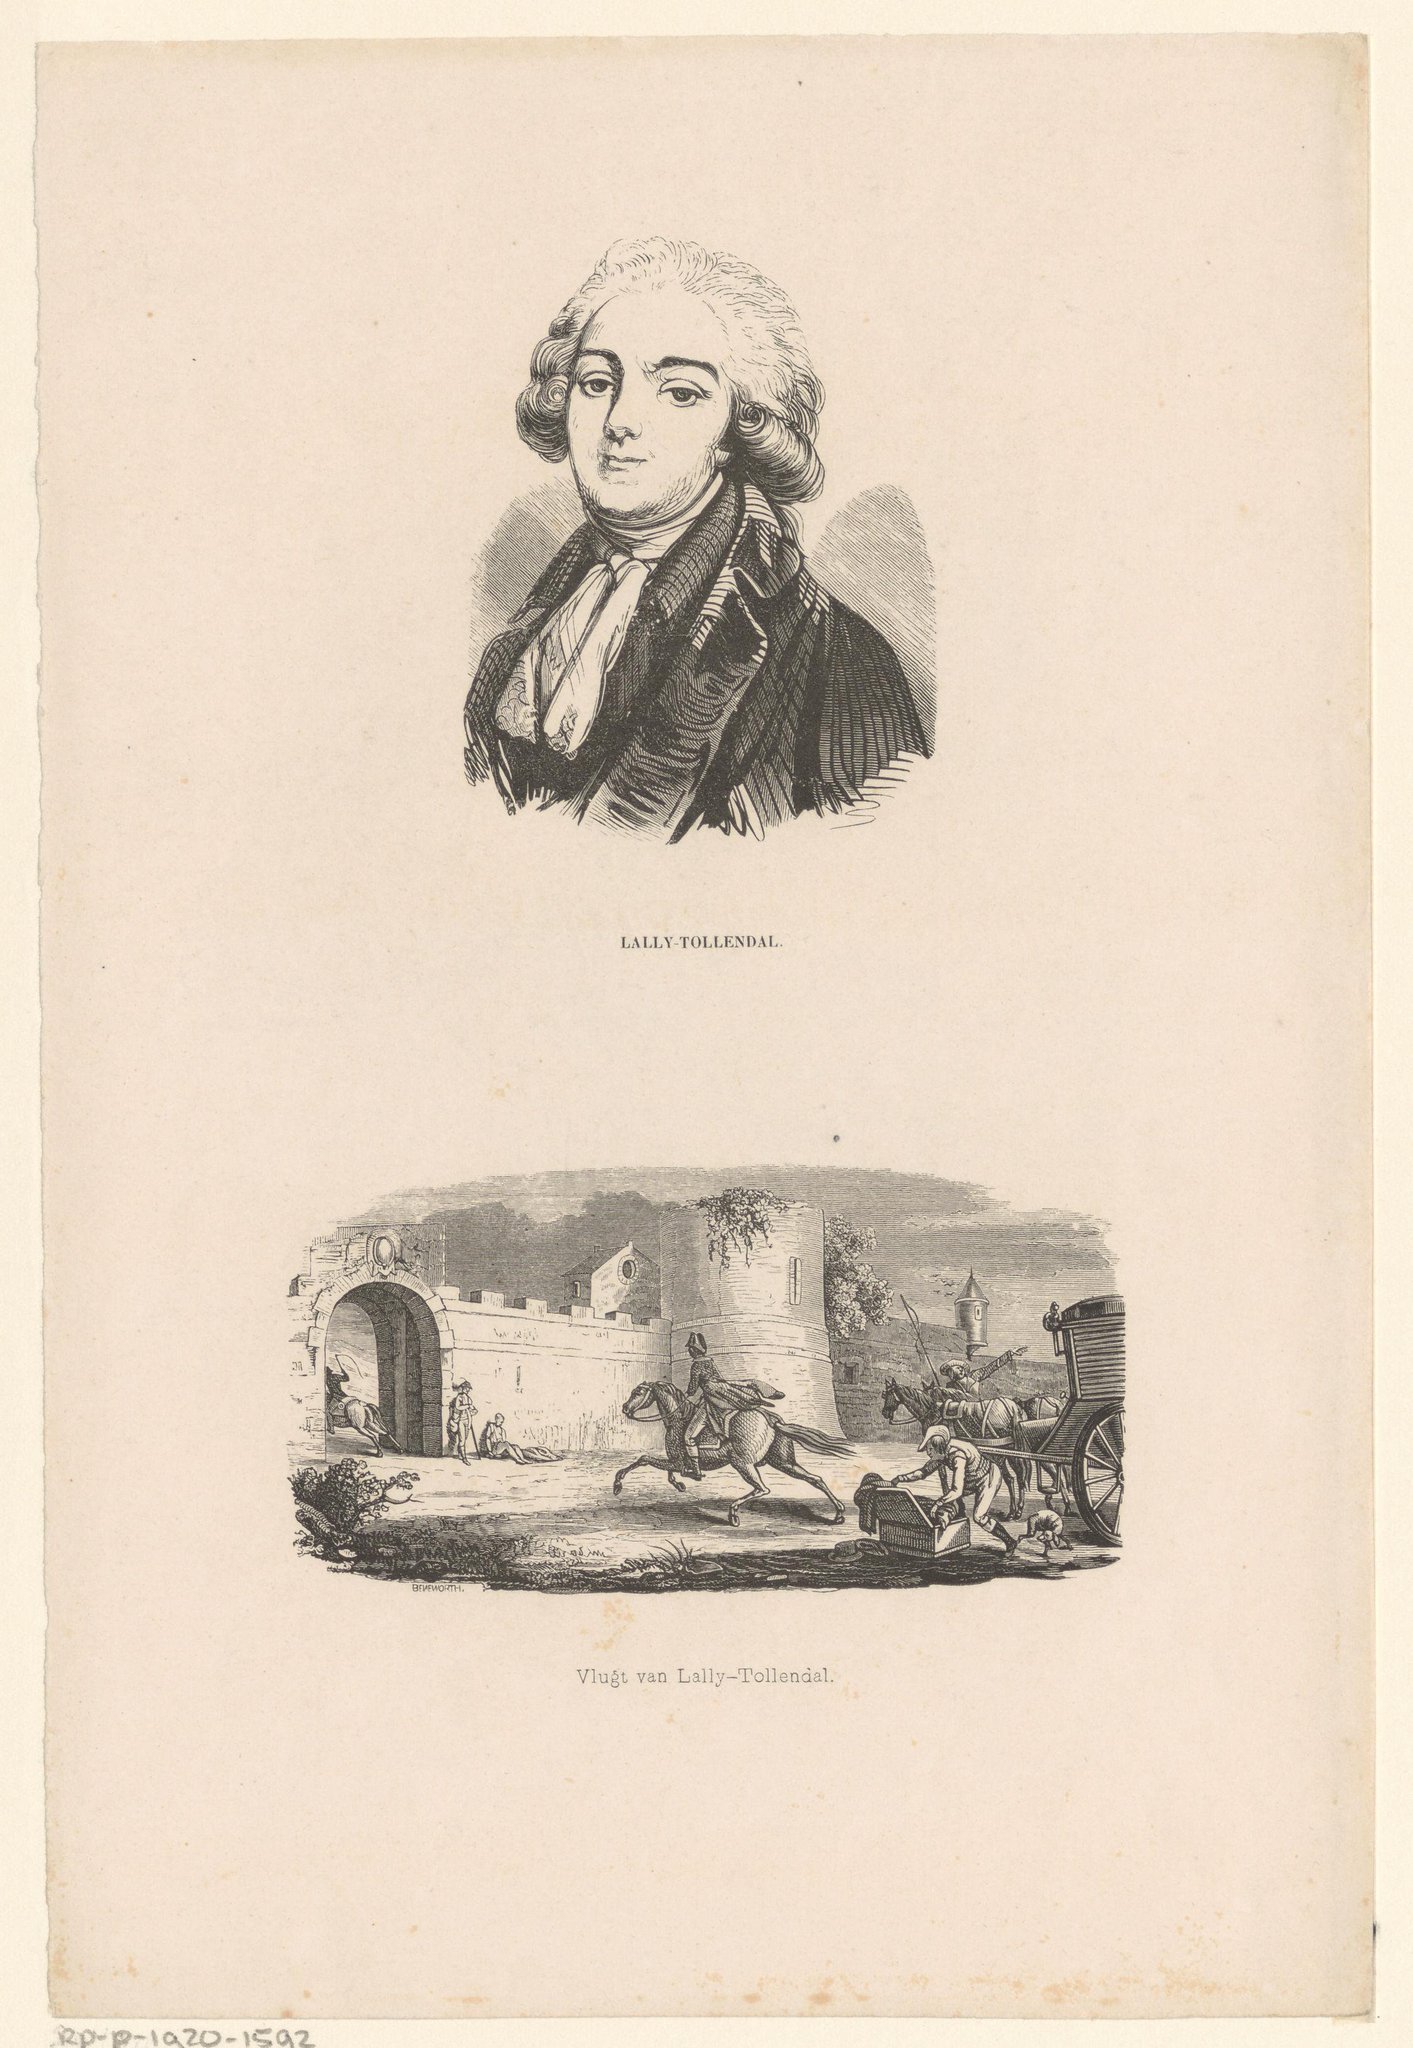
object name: print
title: Portret van Gérard de Lally-Tollendal en de vlucht van Lally-Tollendal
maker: c. beneworth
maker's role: print maker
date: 1820-1850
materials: paper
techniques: letterpress printing, engraving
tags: paris, politician, gérard de lally-tollendal, historical persons, historical events and situations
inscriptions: collector's mark: Lugt 2228